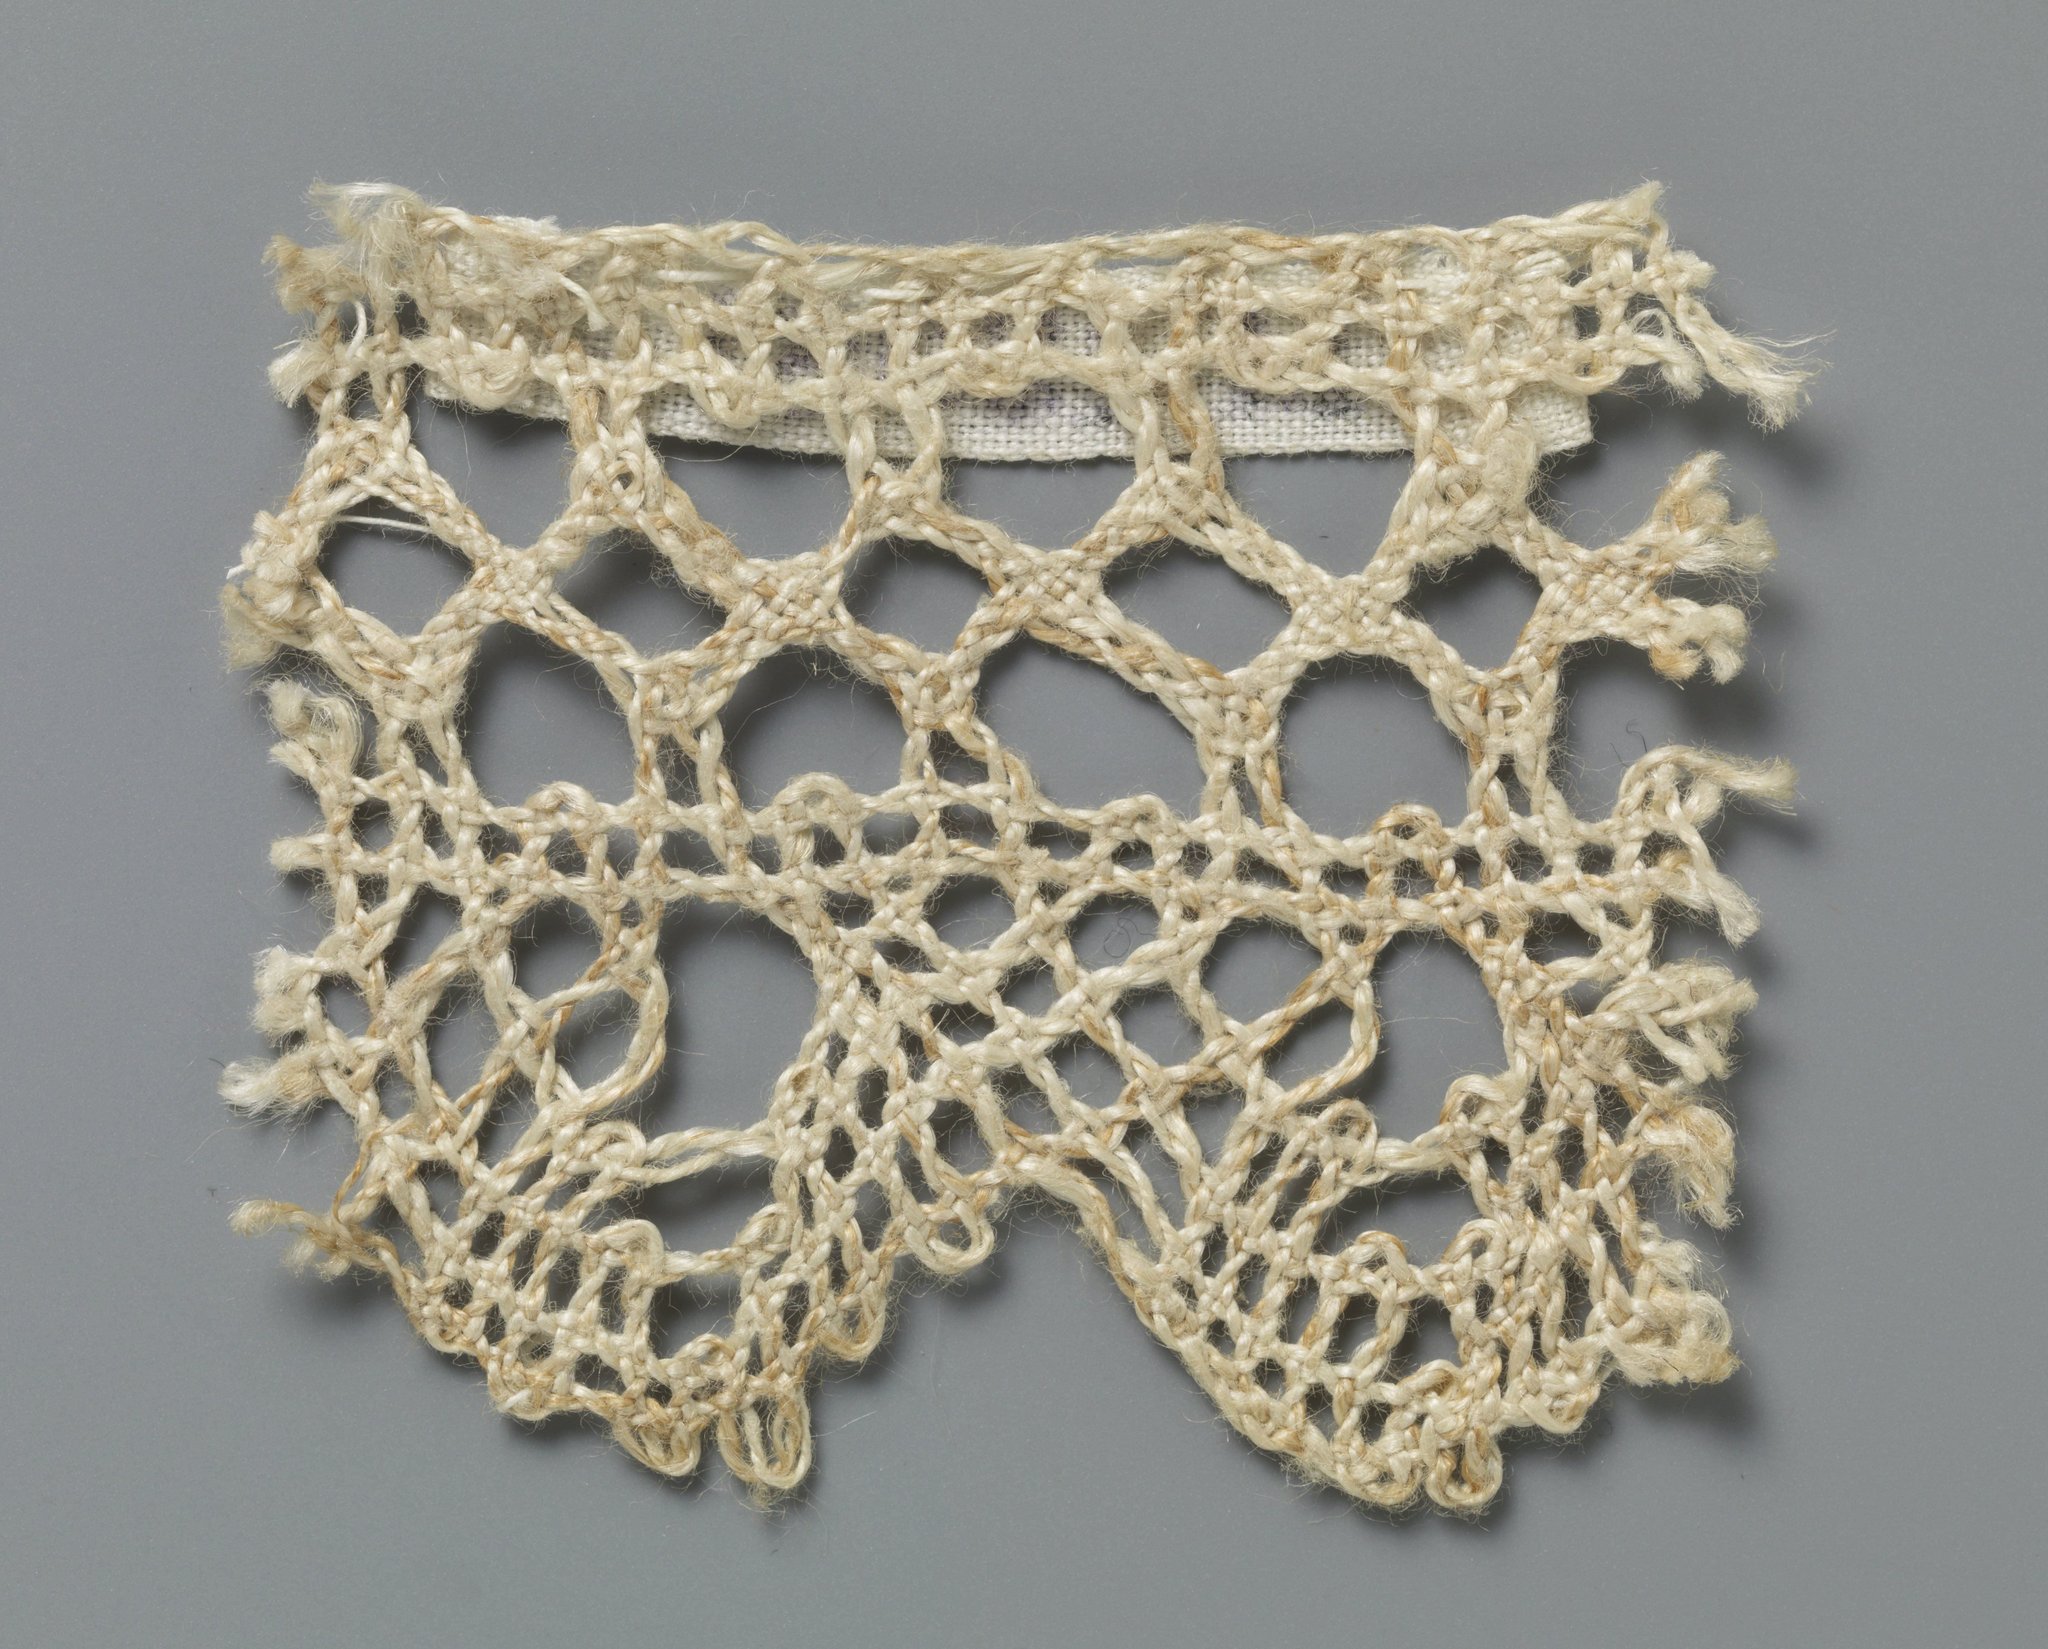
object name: strip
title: Strook kloskant met aaneengeschakelde ruitvormige mazen gemaakt met vlechten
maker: Anonymous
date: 1800-1899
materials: linen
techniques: lace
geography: italy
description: Strook naturelkleurige kloskant: stropkant. Tussen twee zeer smalle banen met een stroptraliegrond vormt een open netwerk van vlechten een rij aaneengeschakelde ruitvormige mazen. Onderaan de strook wordt een schulpenrand gevormd door boogjes in stroptraliegrond. De bovenzijde van de strook is recht afgewerkt.